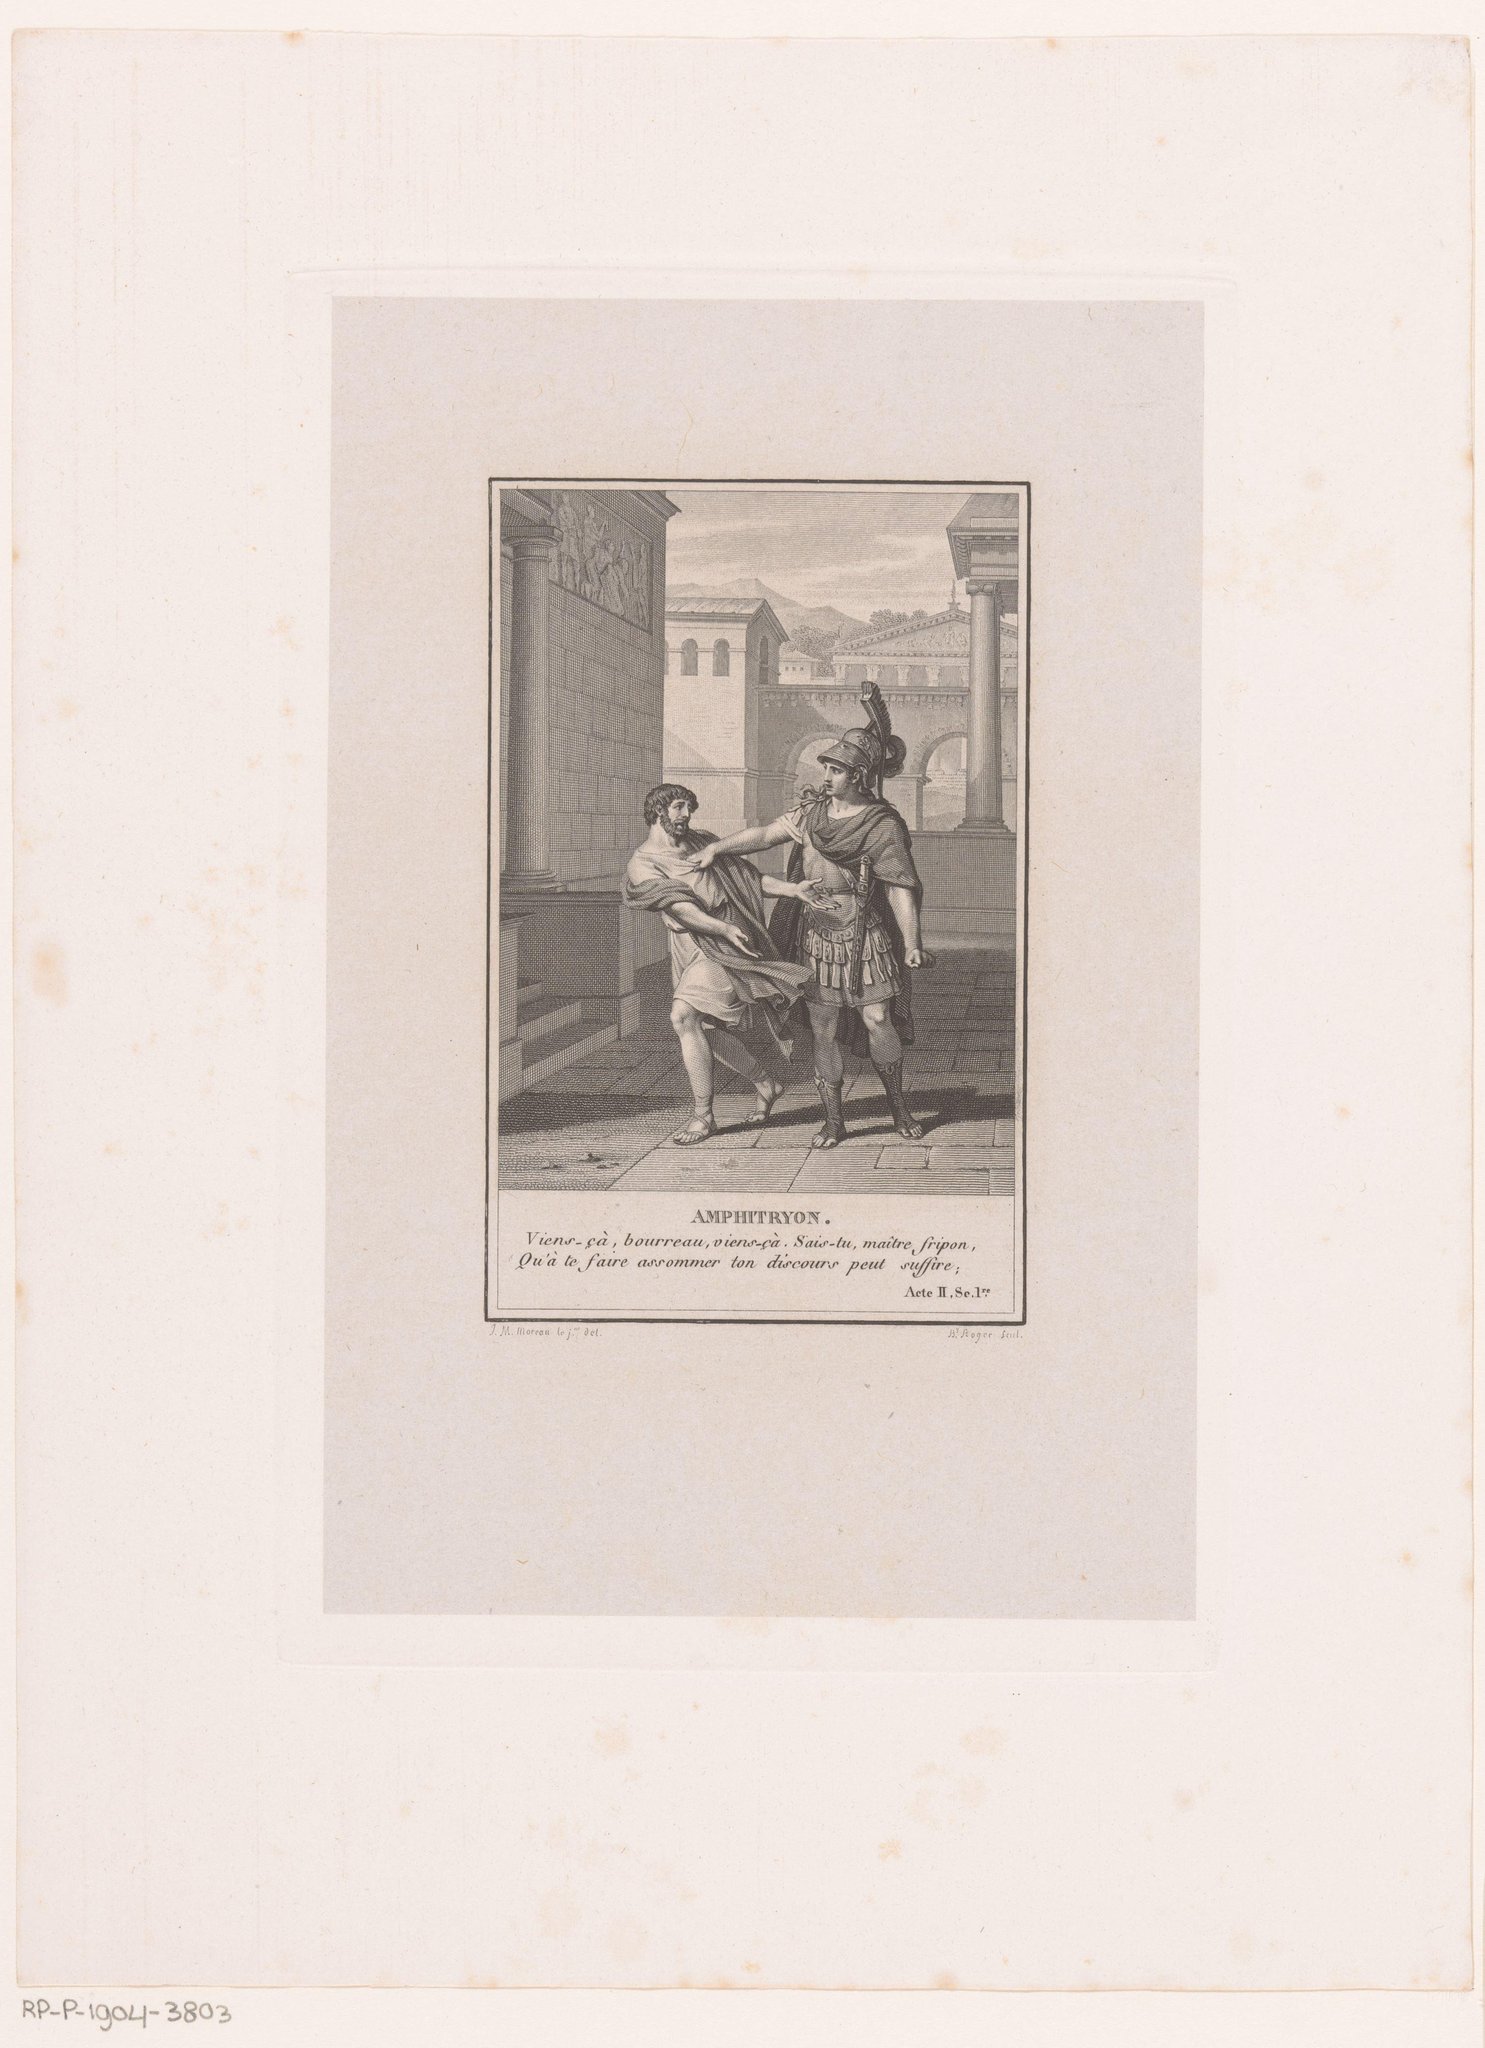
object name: book illustration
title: Amphitryon en zijn bediende Sosie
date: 1811-1813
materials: paper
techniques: engraving, etching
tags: theatre, theatrical performance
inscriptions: collector's mark: Lugt 2228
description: Prent van scène één uit de tweede acte van 'Amphitryon' door Jean Baptiste Molière. Dit betreft één van de dertig prenten, gemaakt in opdracht van Antoine Augustin Renouard, bestemd voor verschillende edities van Molières werk daterend van 1811 tot 1813. De prenten zijn vervaardigd door verschillende kunstenaars naar composities van Moreau.